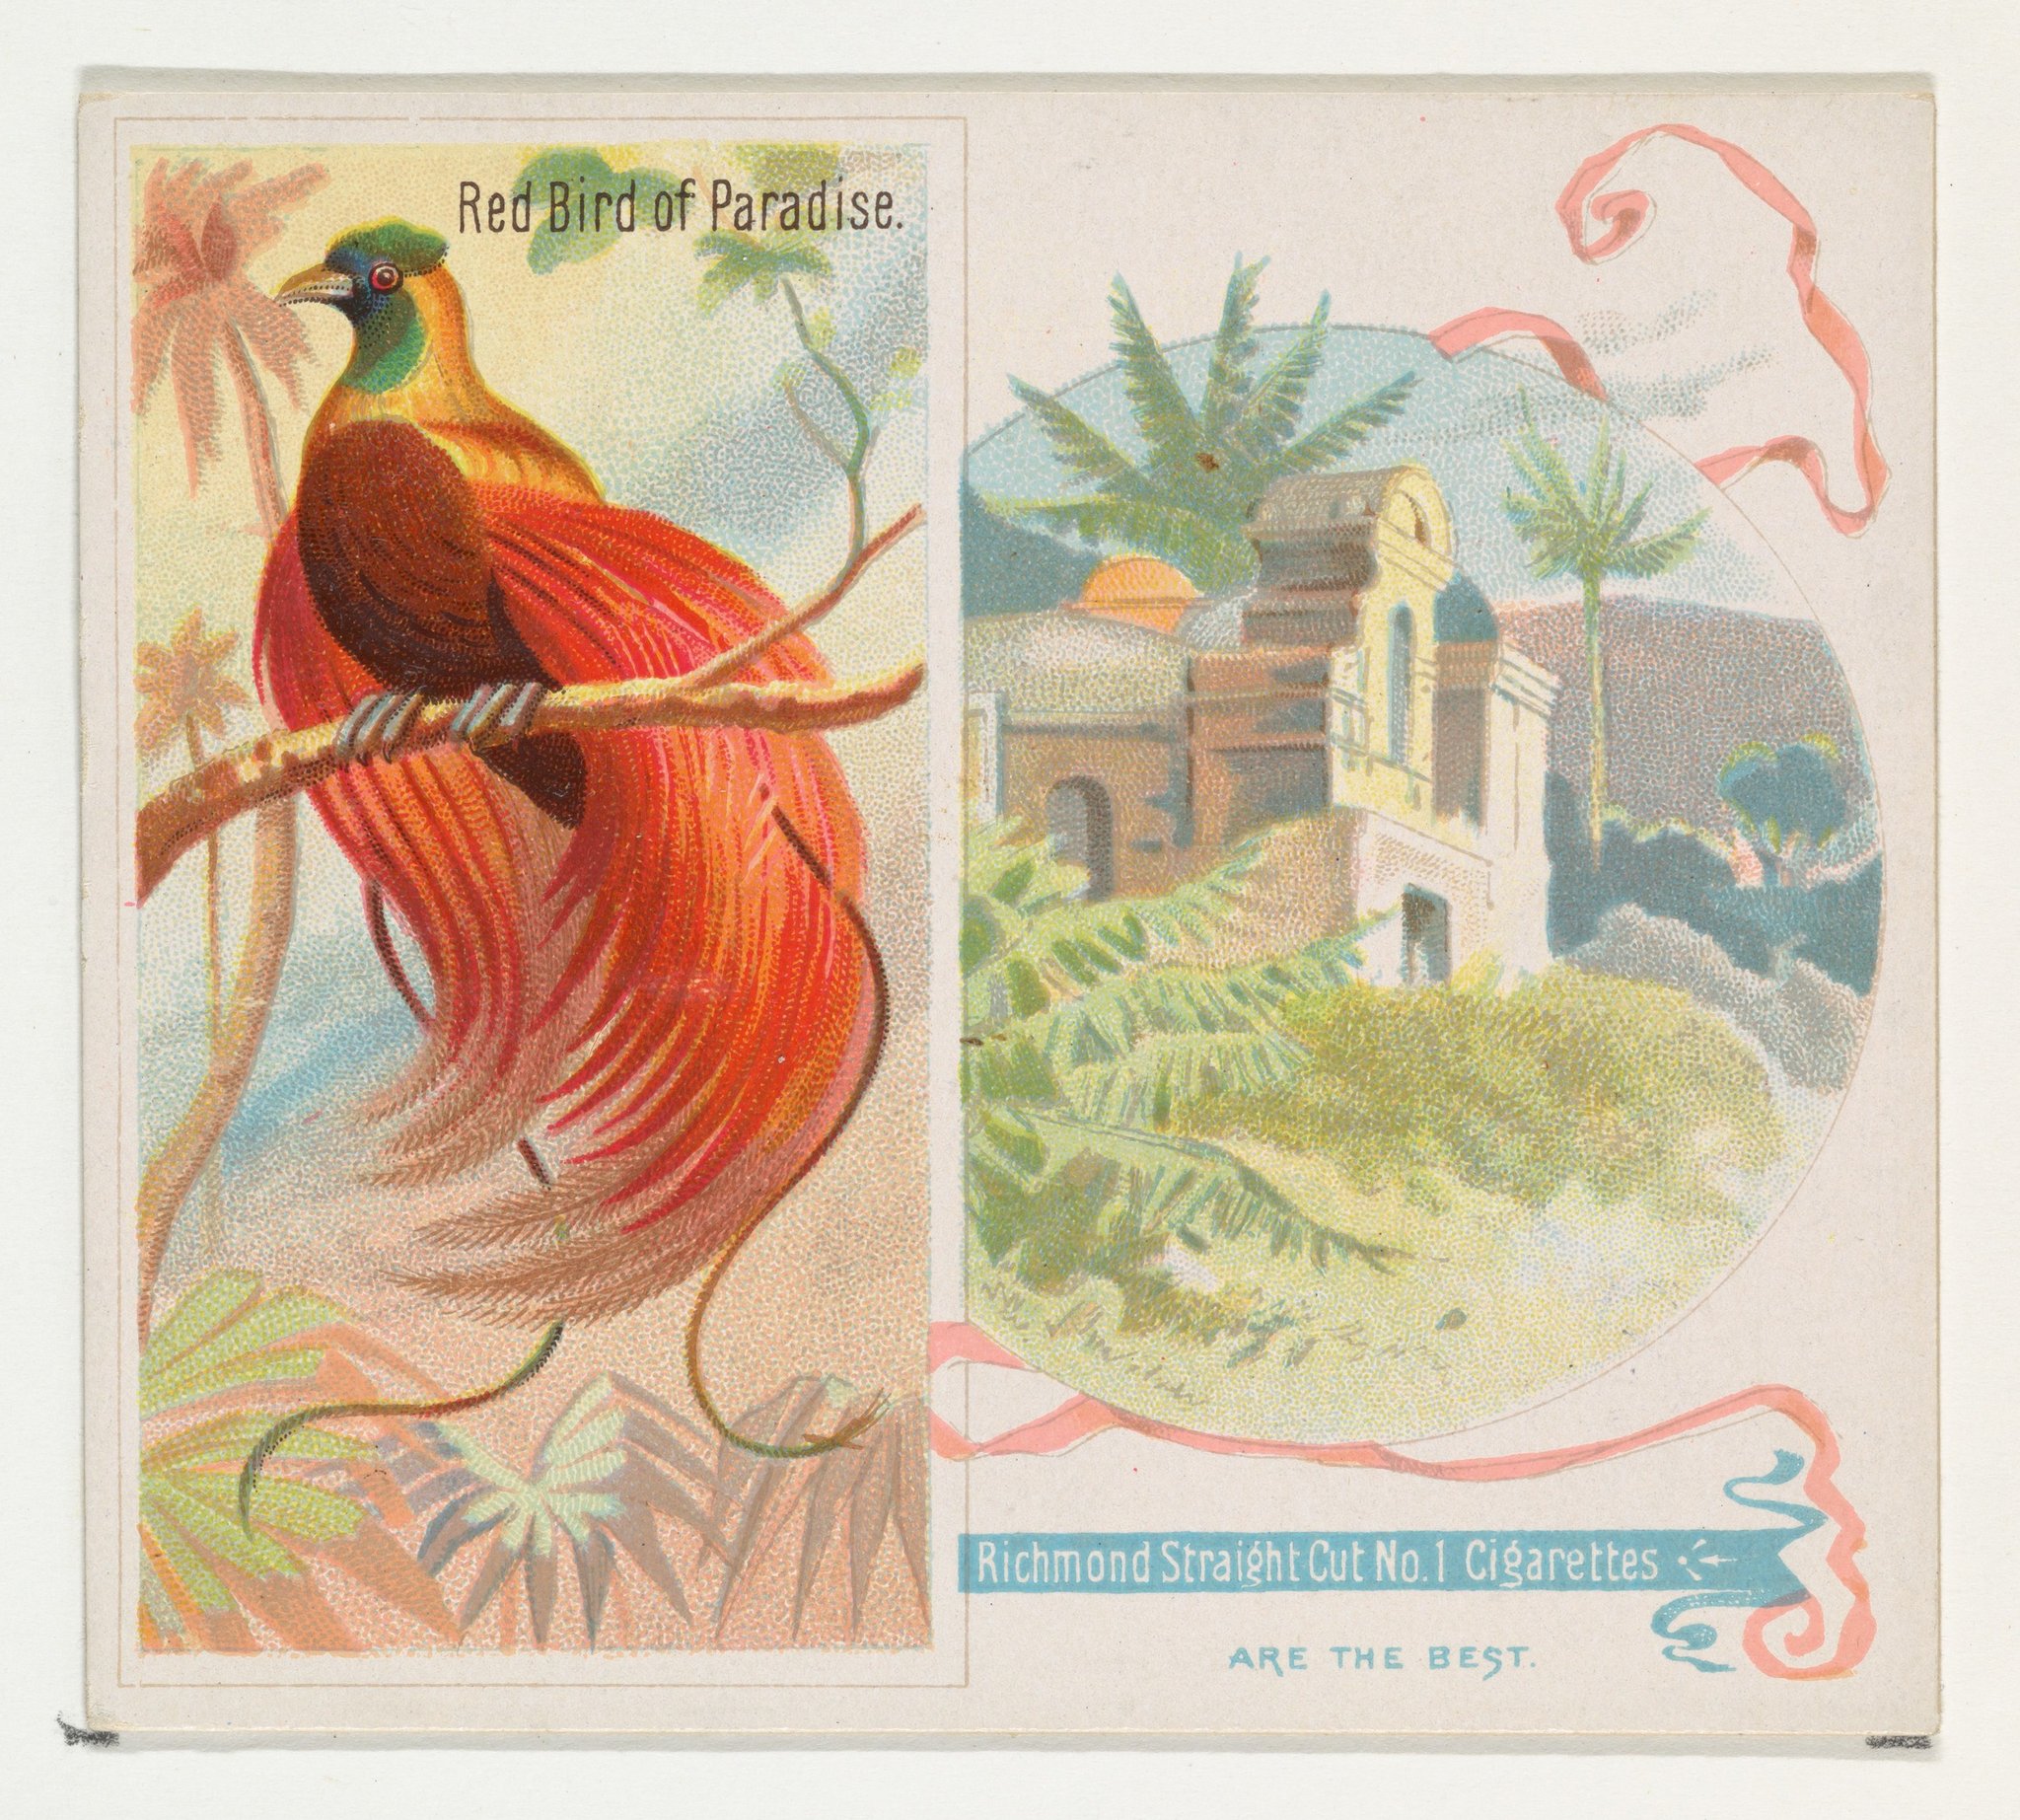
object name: print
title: Red Bird of Paradise, from Birds of the Tropics series (N38) for Allen & Ginter Cigarettes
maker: allen & ginter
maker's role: publisher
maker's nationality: american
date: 1889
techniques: color lithograph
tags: birds